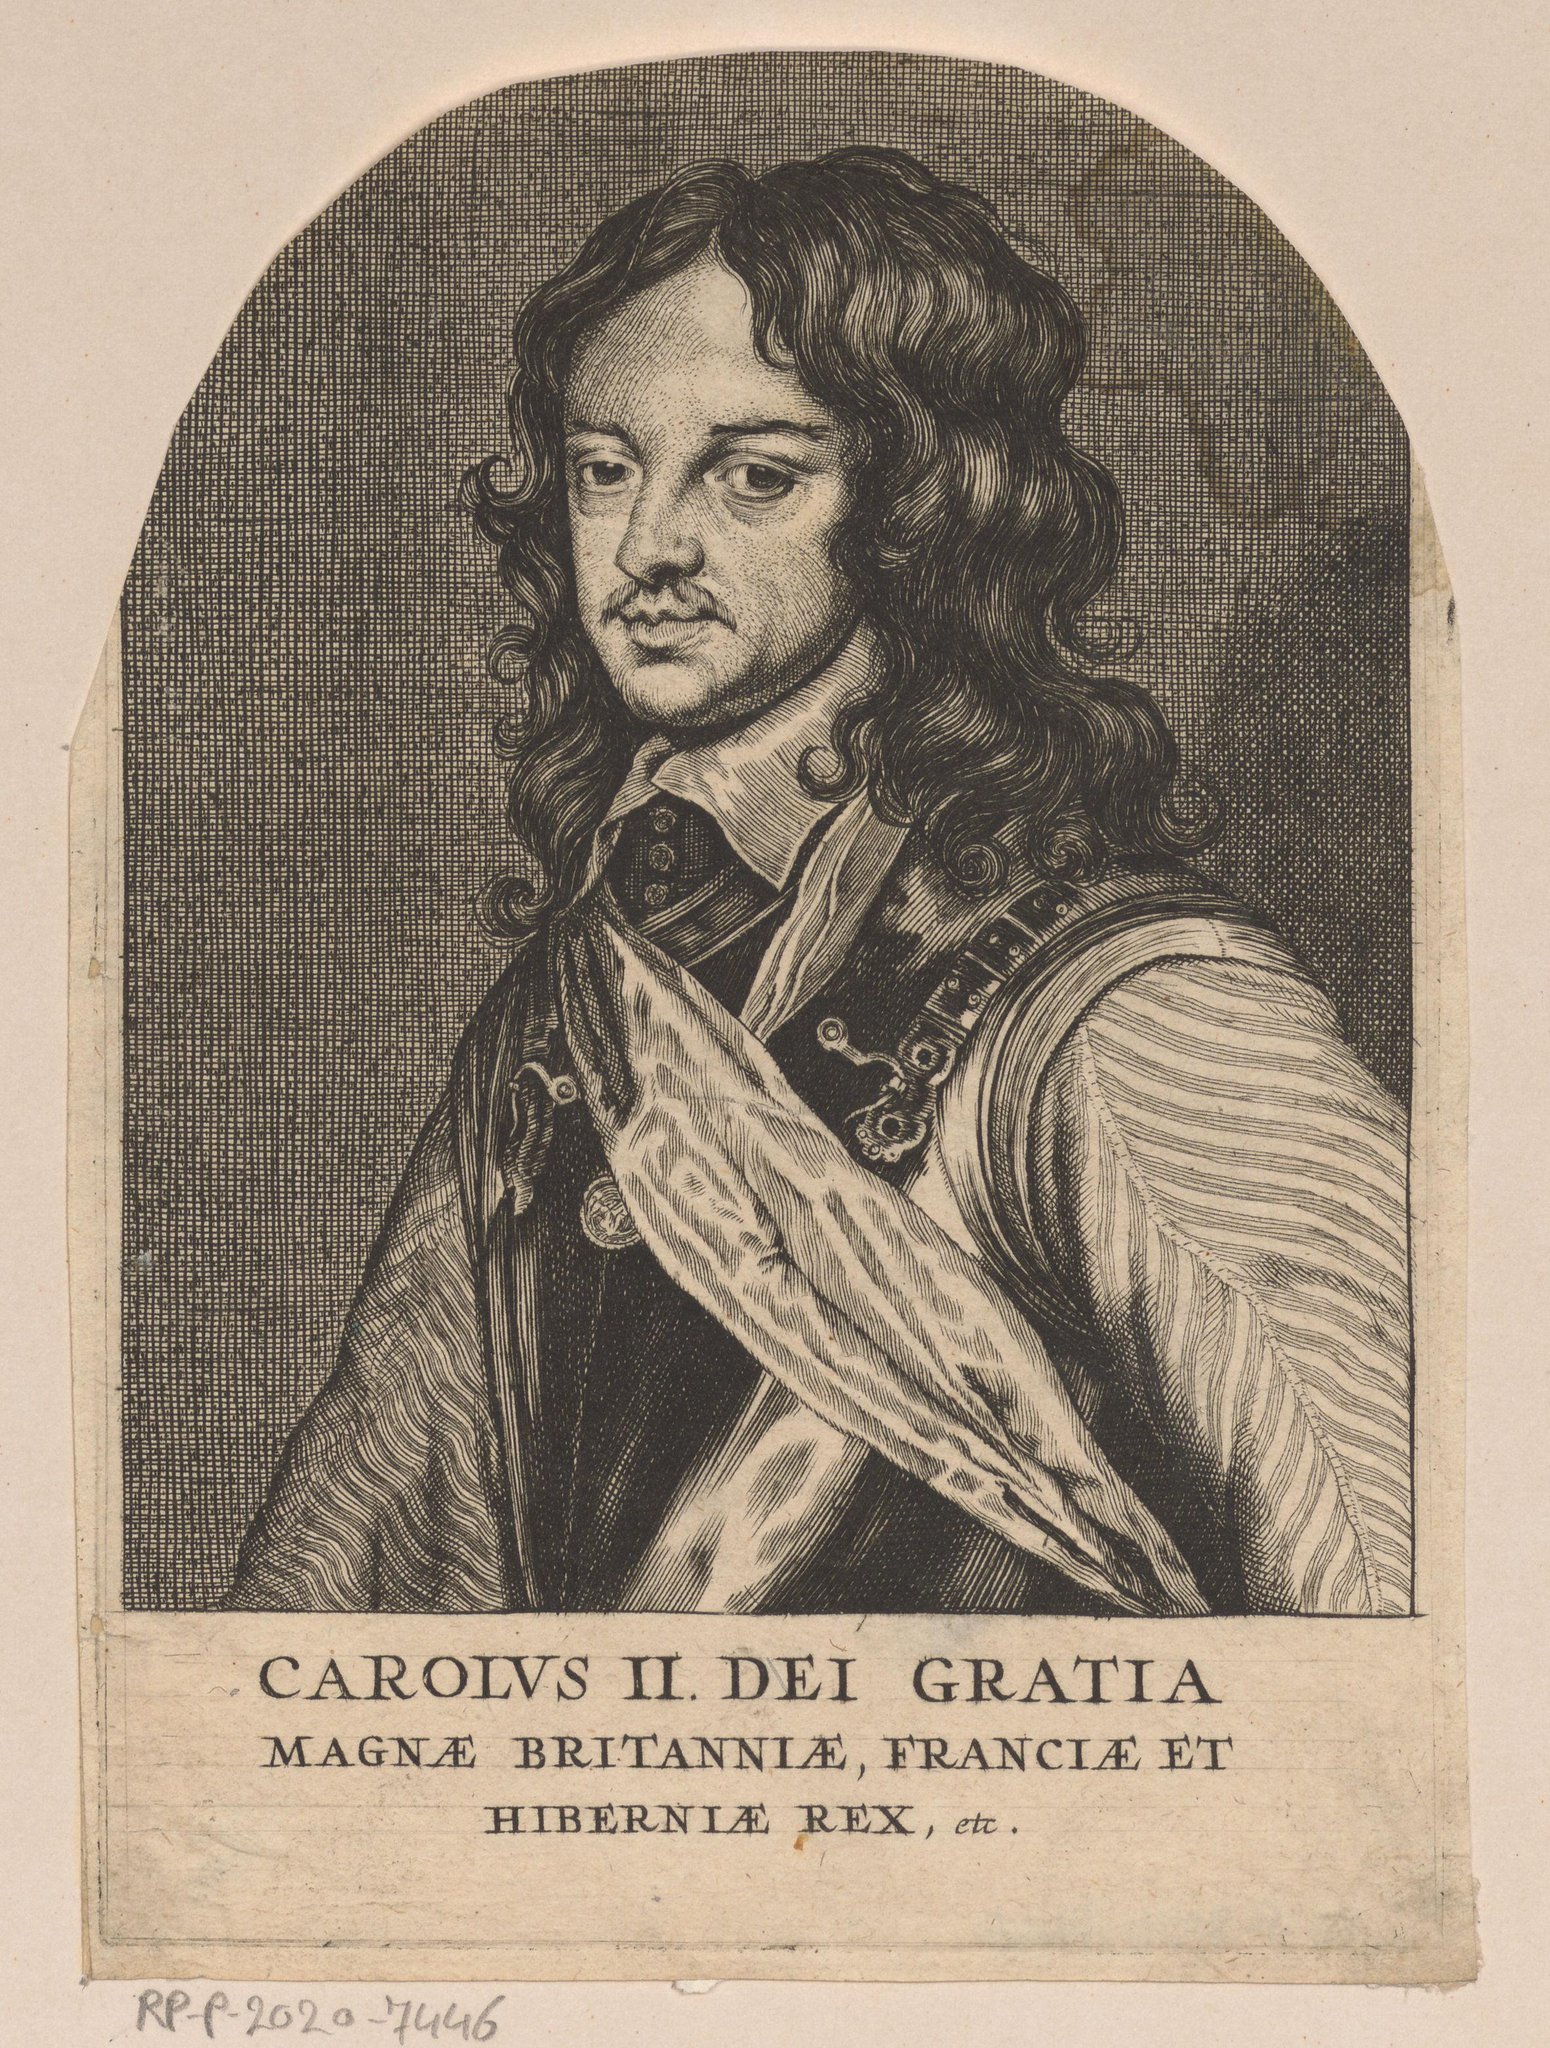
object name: print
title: Portret van Karel II, koning van Engeland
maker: Anonymous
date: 1660-1699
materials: paper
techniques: engraving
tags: karel ii (koning van engeland), historical persons, king